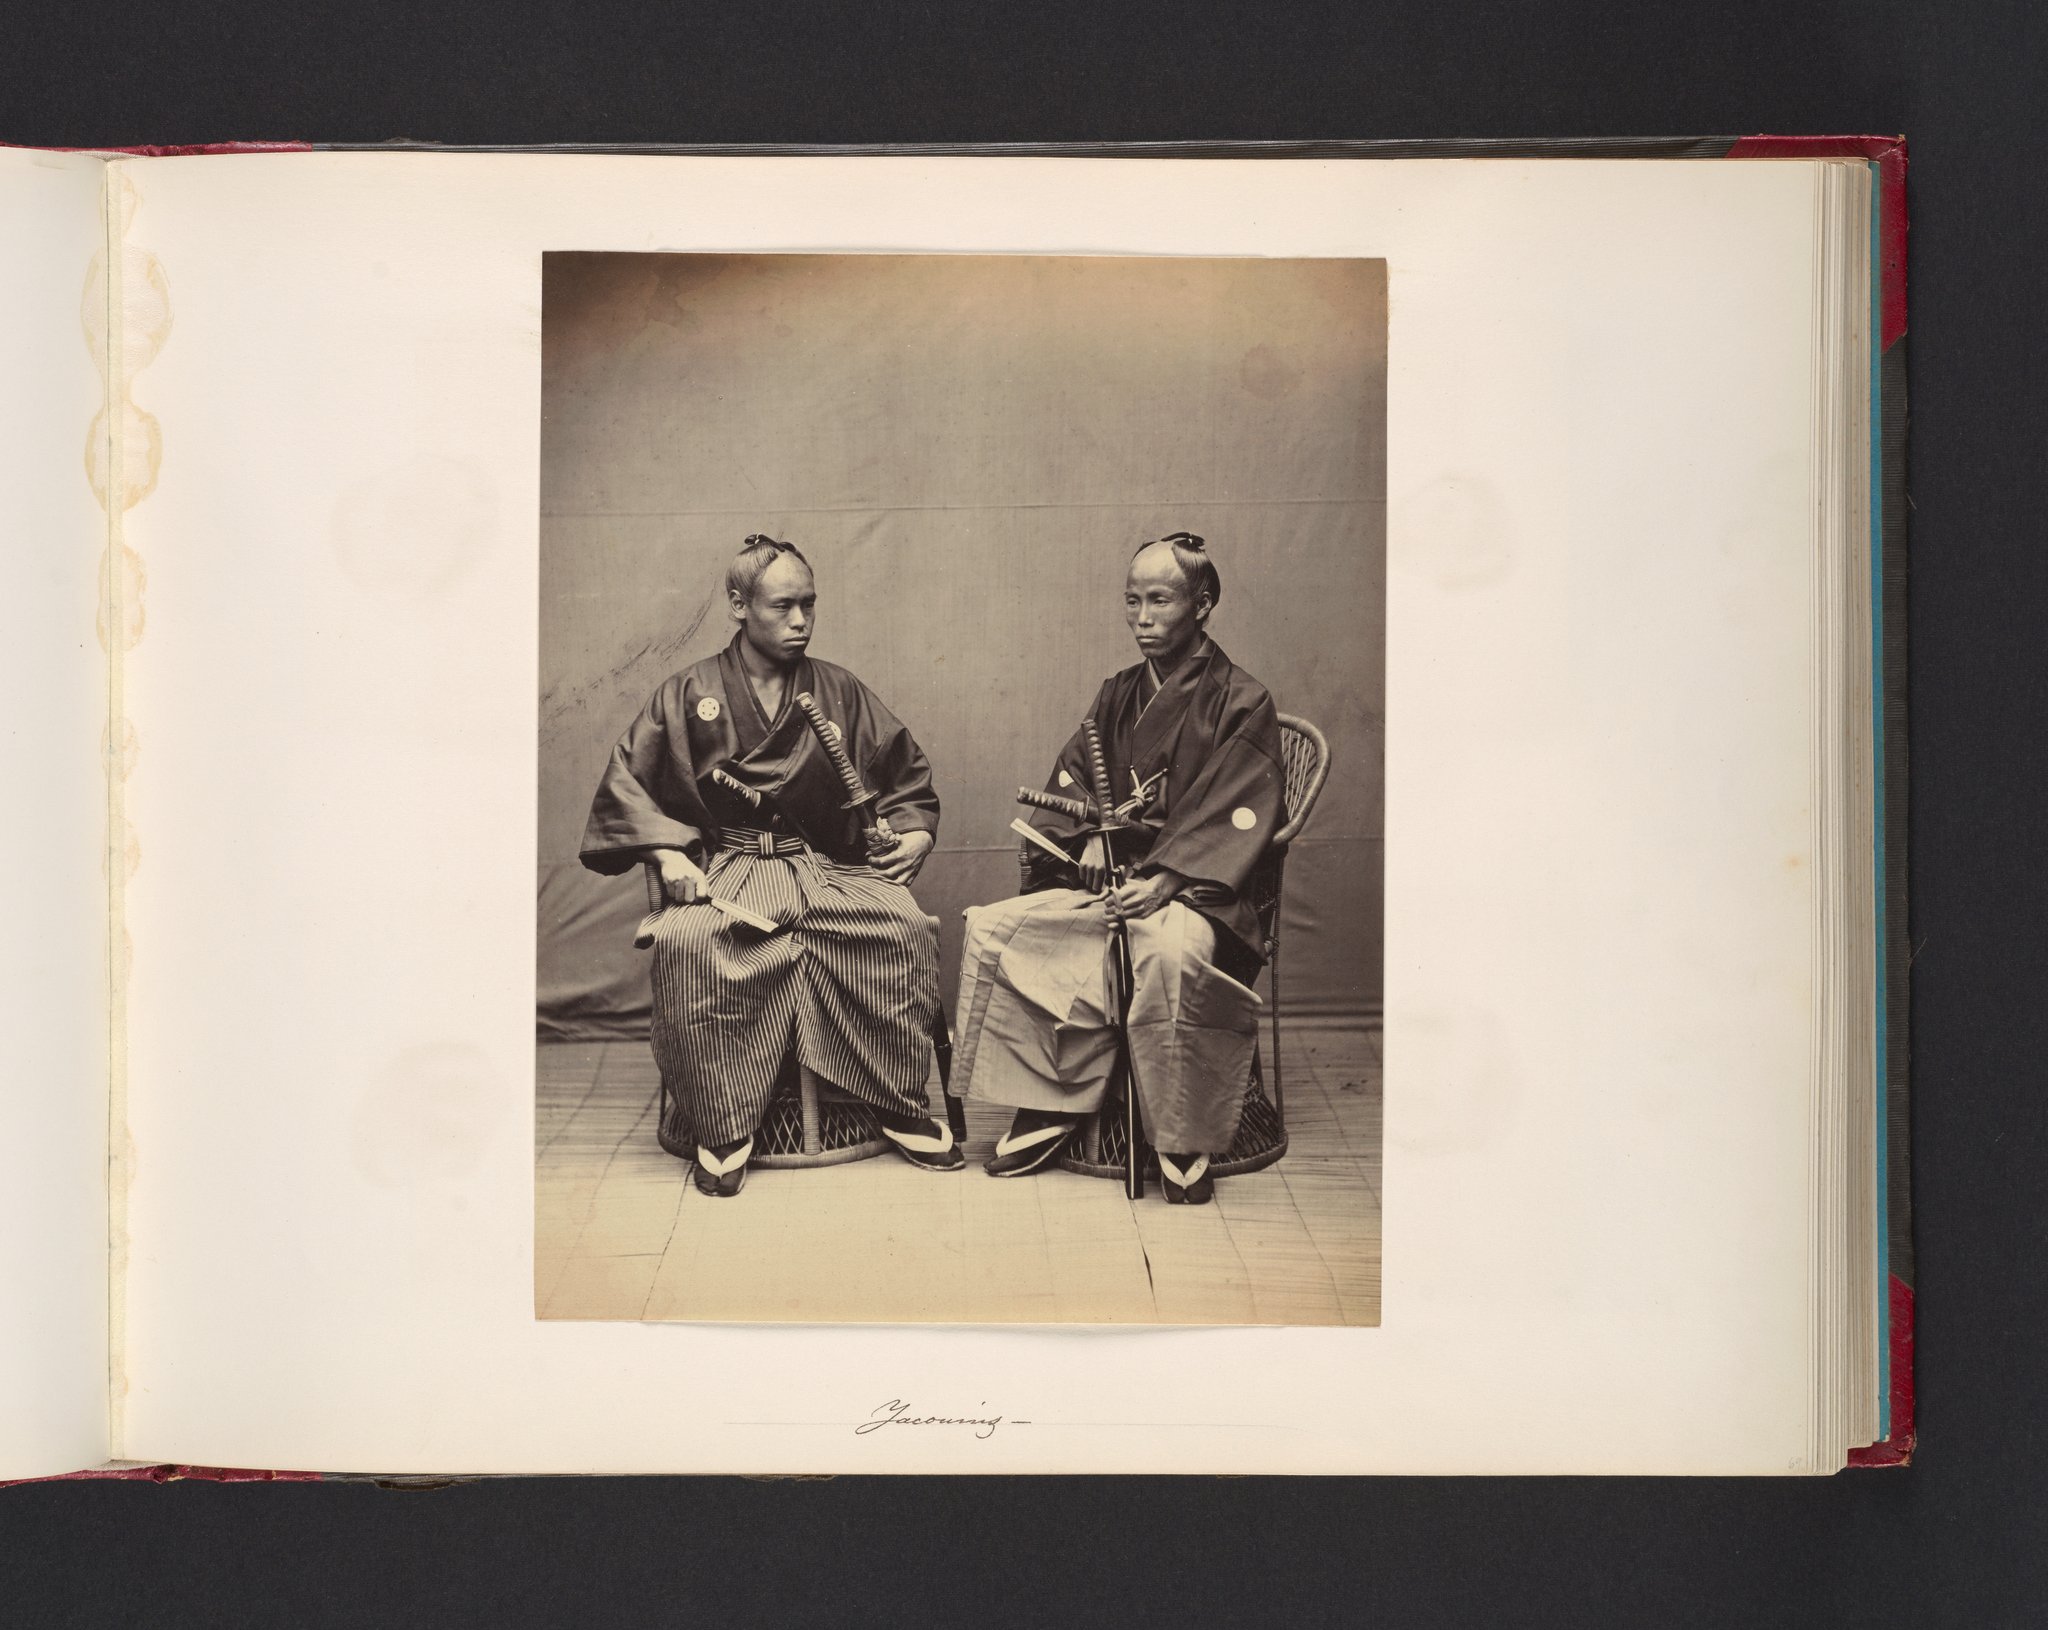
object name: photograph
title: [Portrait of Two Government Officials]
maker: john thomson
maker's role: artist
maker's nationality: british, scottish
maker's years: 1837-1921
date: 1865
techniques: albumen silver print, glass negative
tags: swords,men,portraits